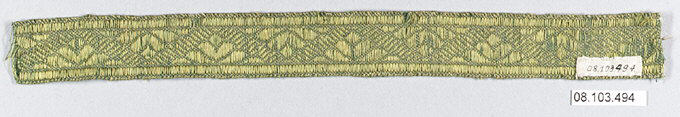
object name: galloon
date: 1701-1800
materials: cotton, silk